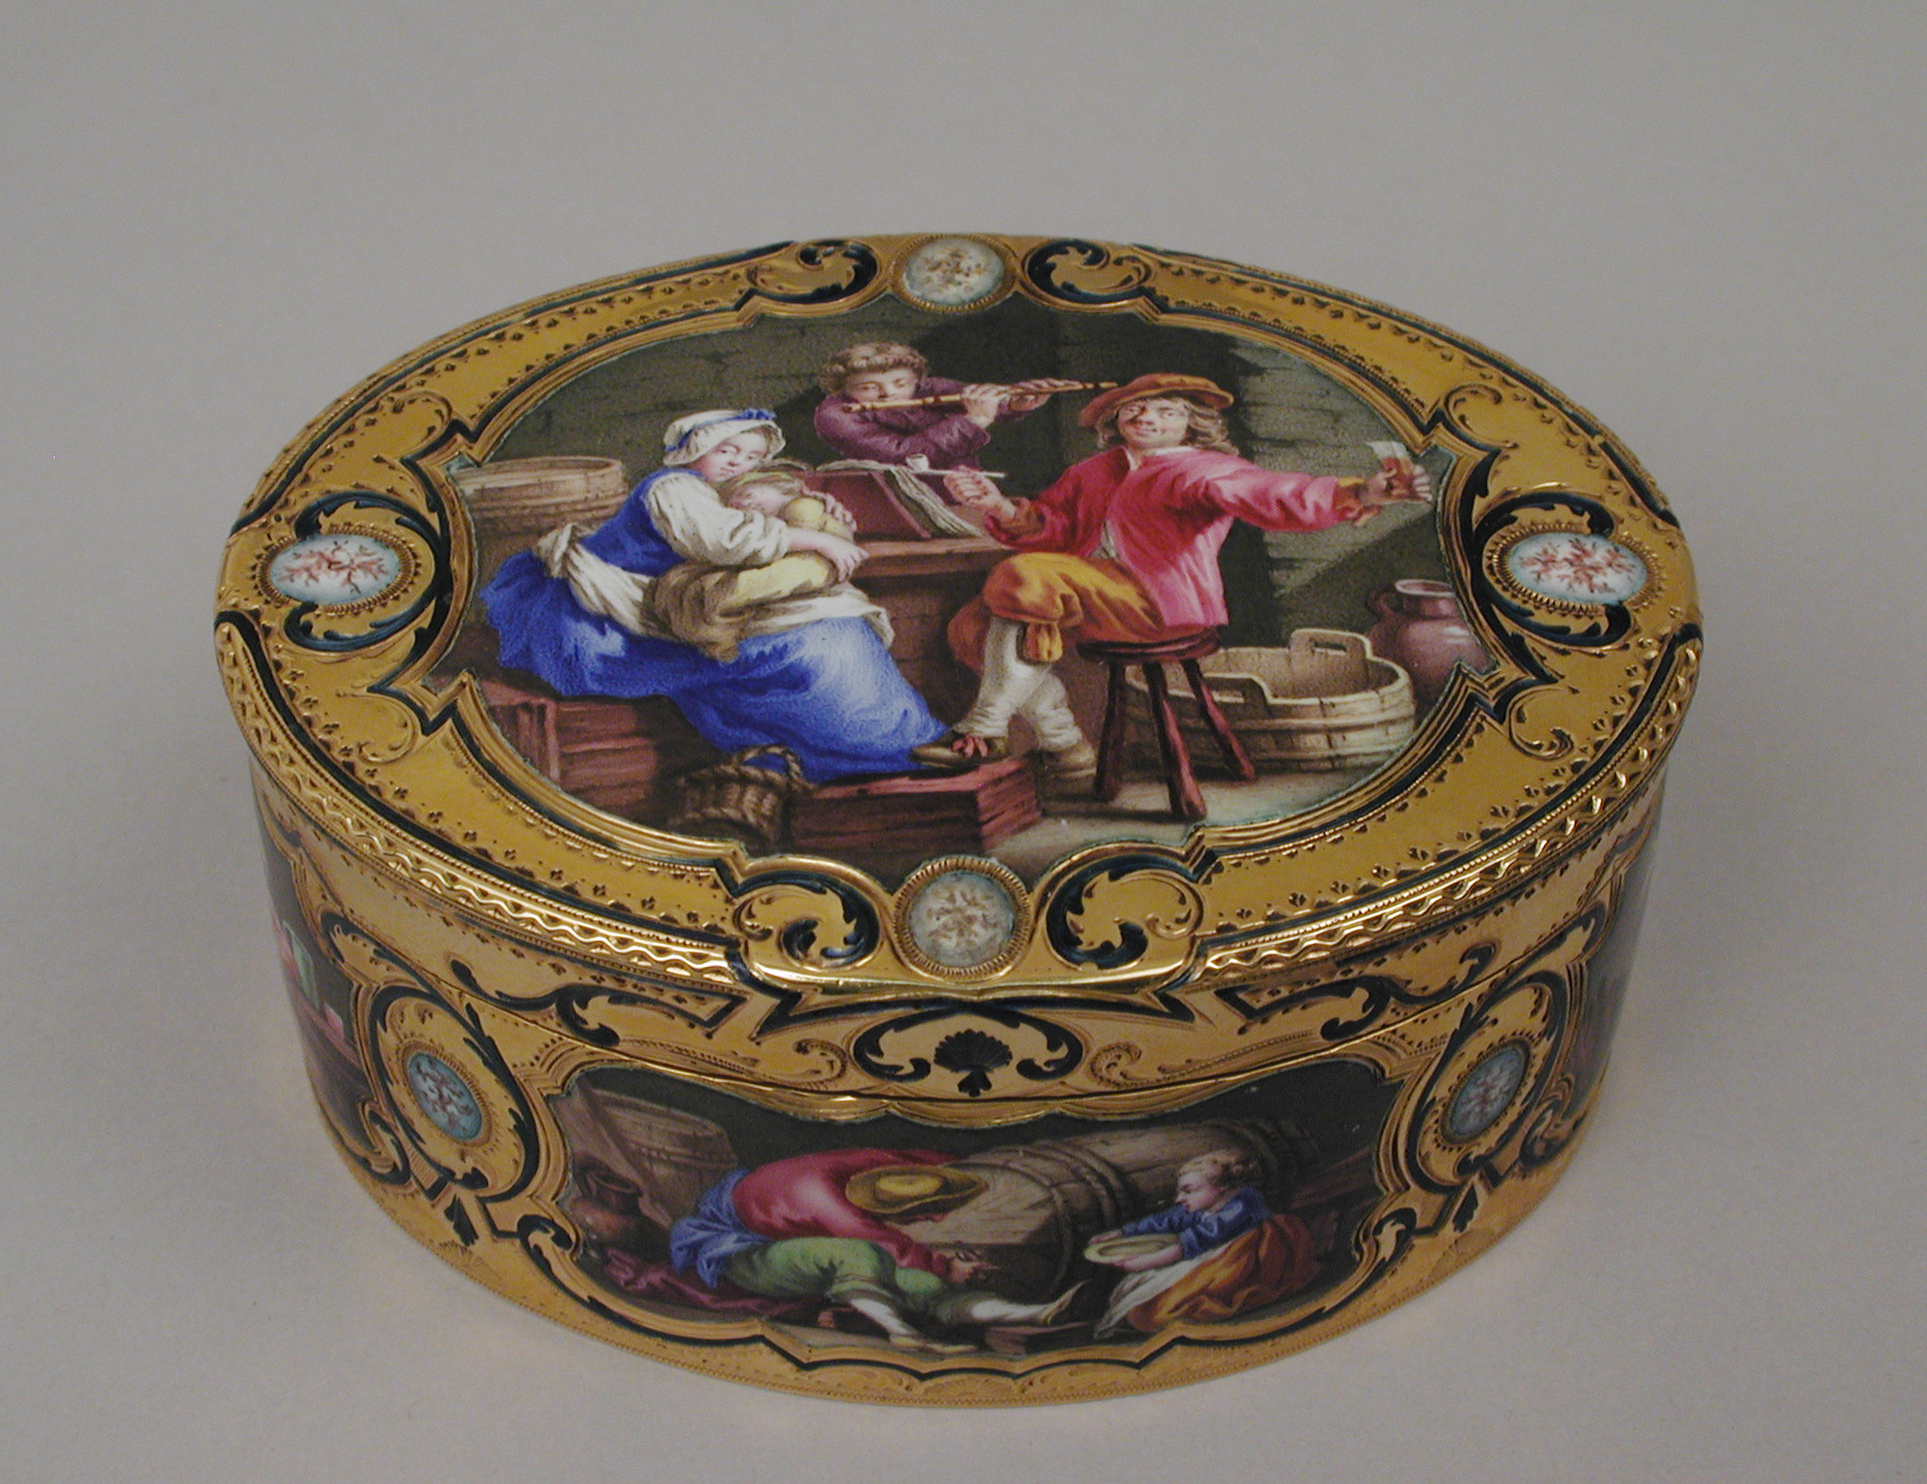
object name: snuffbox, painting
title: Snuffbox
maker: paul robert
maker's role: maker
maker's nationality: french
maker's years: 1720-1779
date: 1758-1759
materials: enamel, gold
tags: men,women,flutes